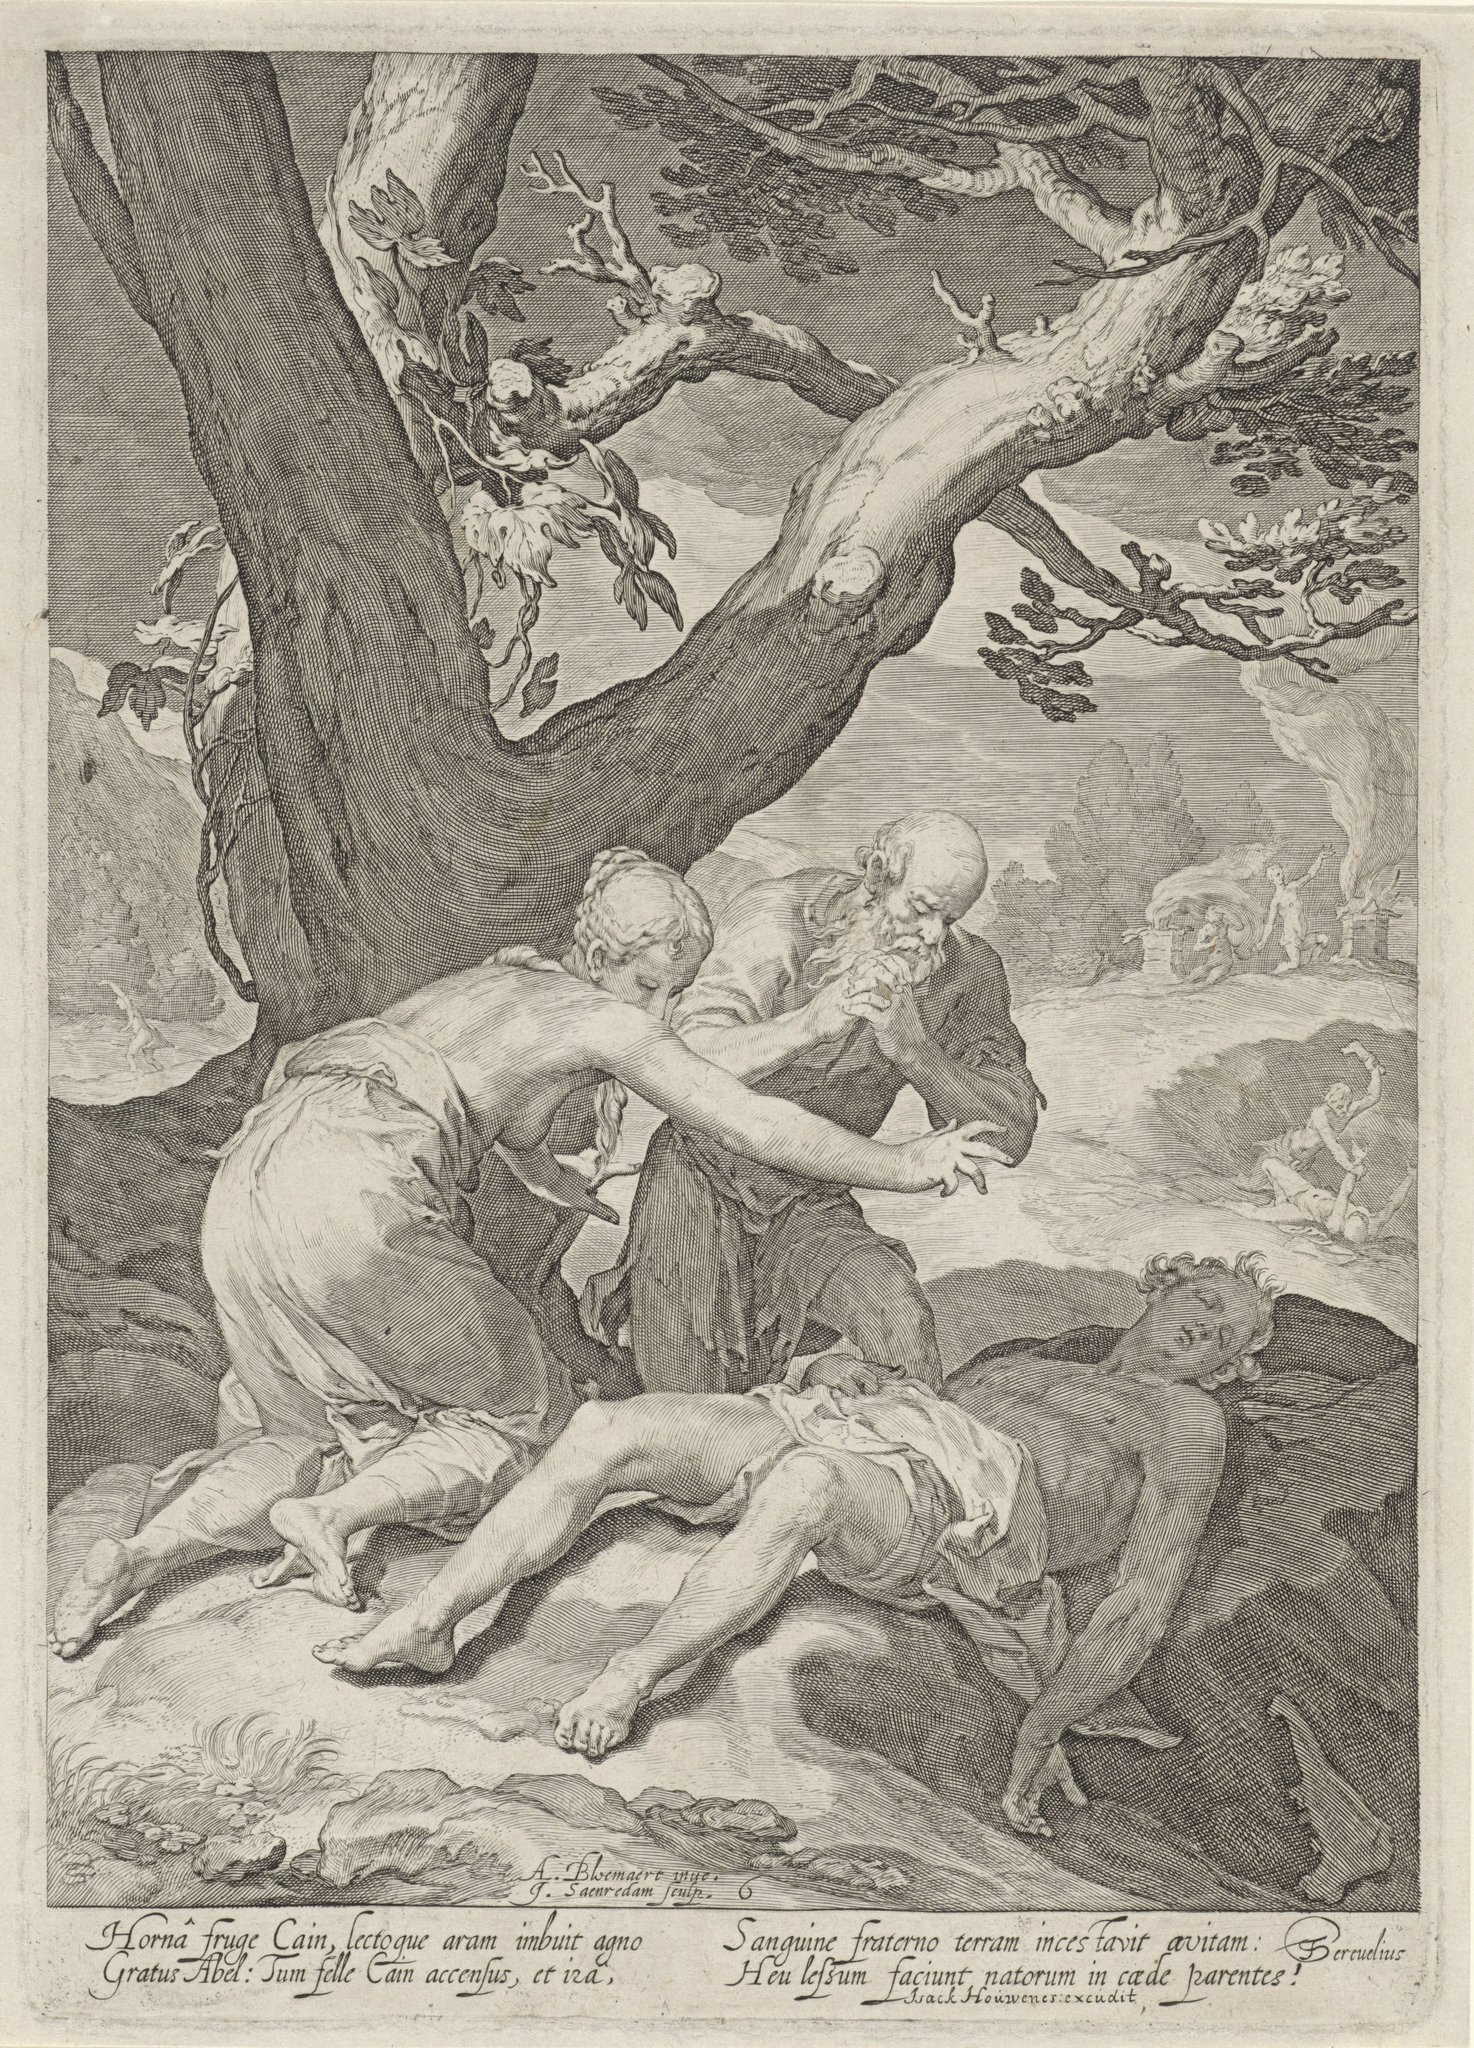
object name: print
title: Adam en Eva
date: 1604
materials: paper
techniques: engraving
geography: assendelft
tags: the killing of abel: cain slays him with a stone, a club or a jaw-bone, alternatively with a spade or another tool as weapon, adam and eve discover the dead body of abel and grieve over it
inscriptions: collector's mark: Lugt 2228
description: Adam en Eva vinden de dode Abel bij de offerplaats. Beiden zitten op hun knieën voor het lijk van hun zoon en treuren. Op de achtergrond het offer van Abel en Kaïn en de moord op Abel.